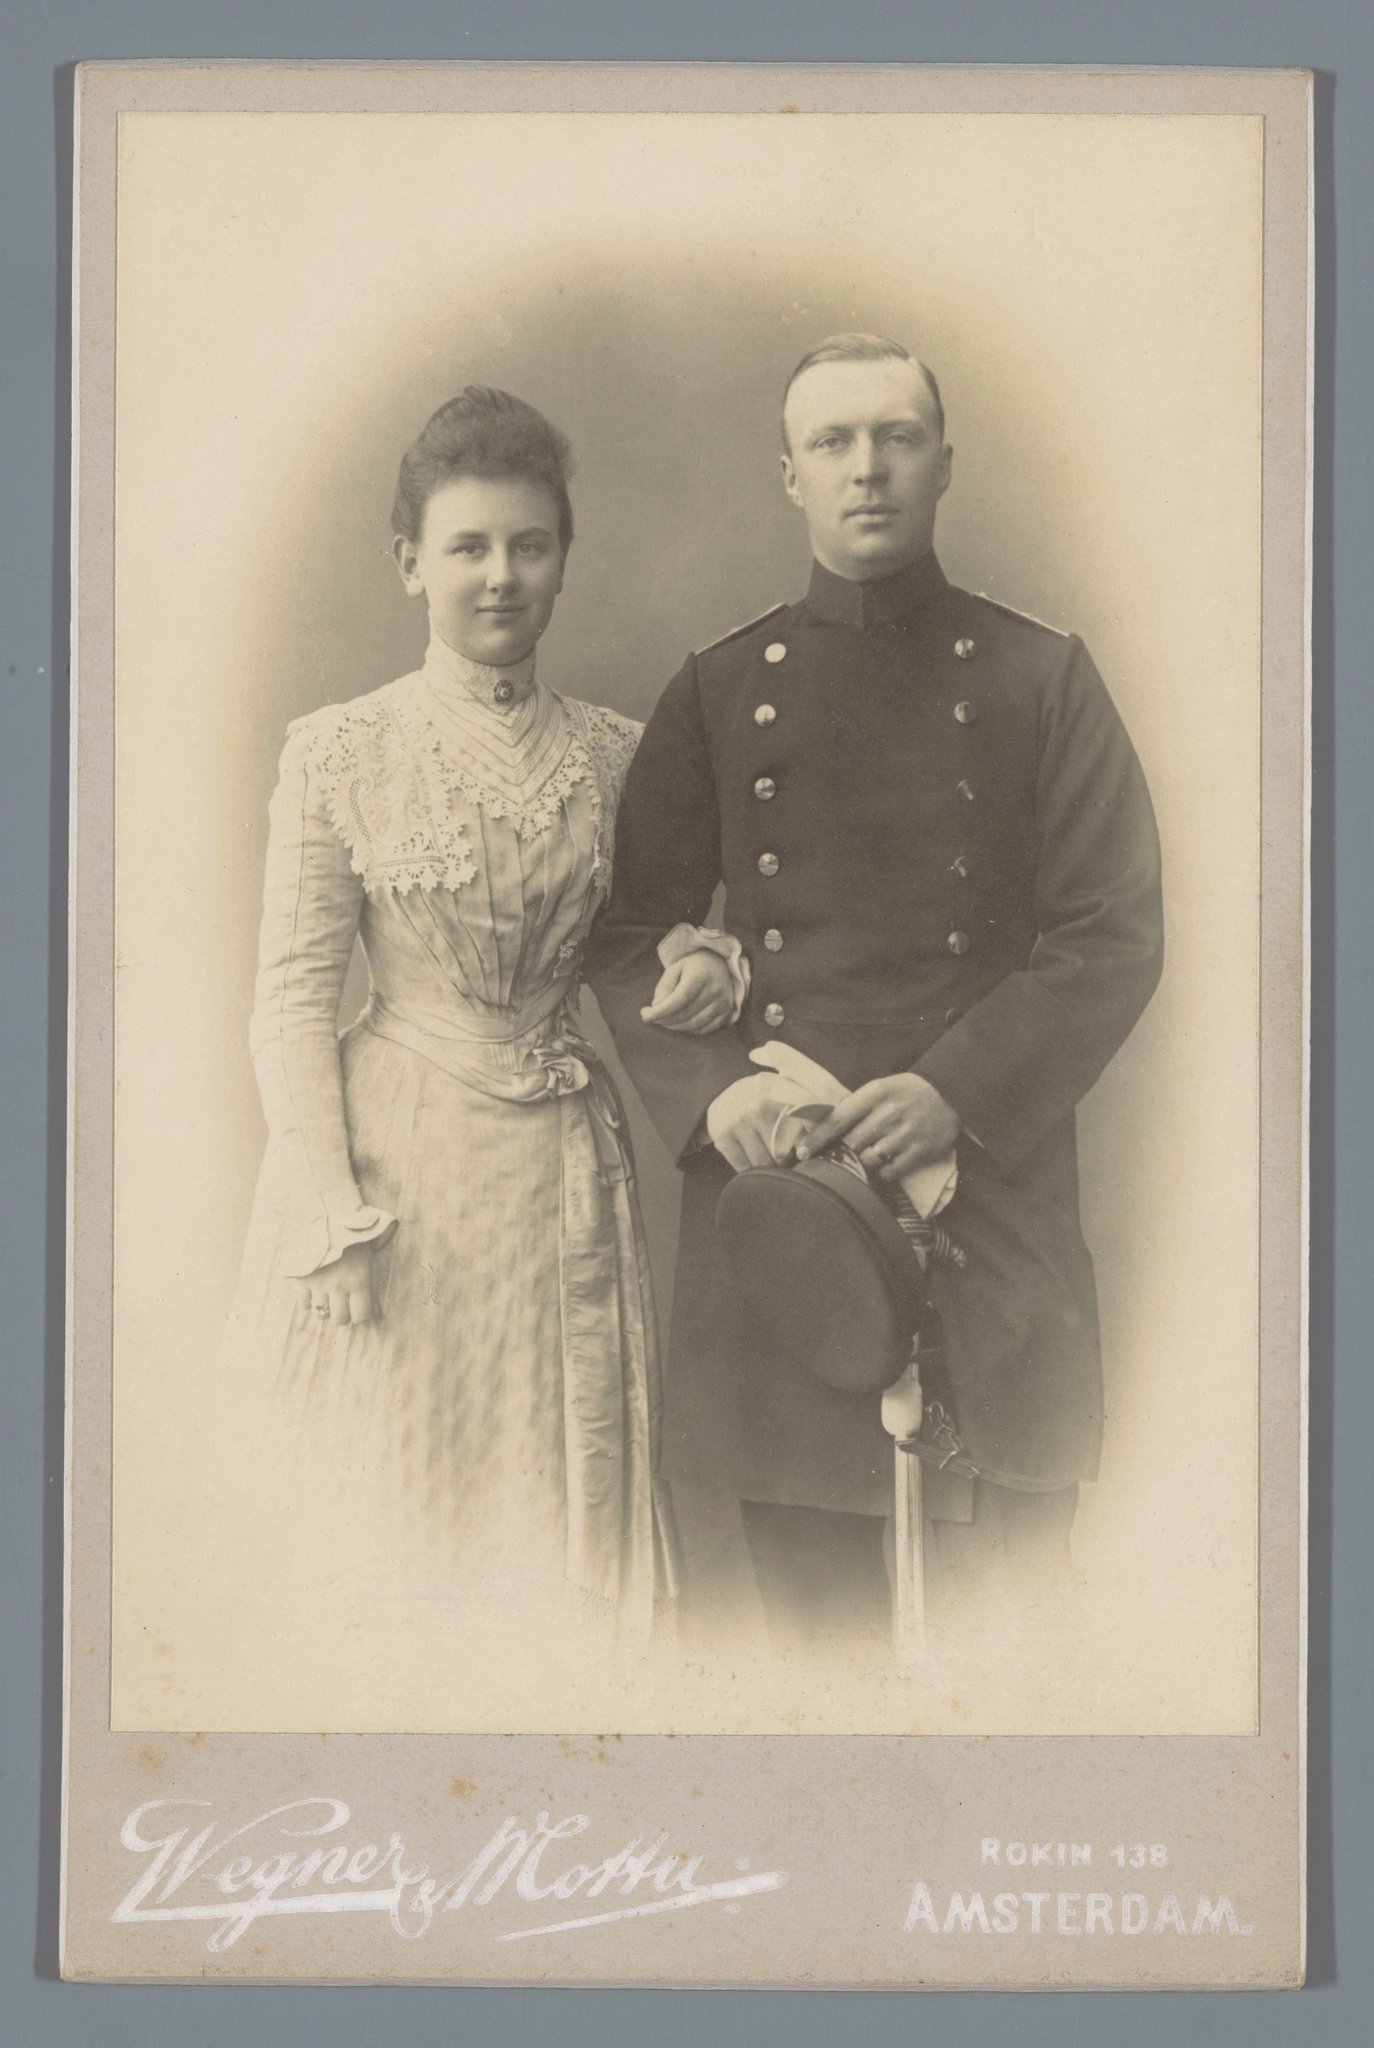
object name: cabinet photograph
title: Verlovingsportret van koningin Wilhelmina en prins Hendrik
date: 1900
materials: cardboard, photographic support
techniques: gelatin silver print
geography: amsterdam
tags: the hague, print maker, wilhelmina of the netherlands, hendrik (prins der nederlanden (1876-1934)), prince, queen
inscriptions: stamp: ‘M. M. OLIVIER/ ROkin/ ALGEMEENE BOEKHANDEL/ 70/ AMSTERDAM’, inscription: ‘December 1900 -/ WIlhelmina + Hendrik’, address: ‘ROKIN 138/ AMSTERDAM.’